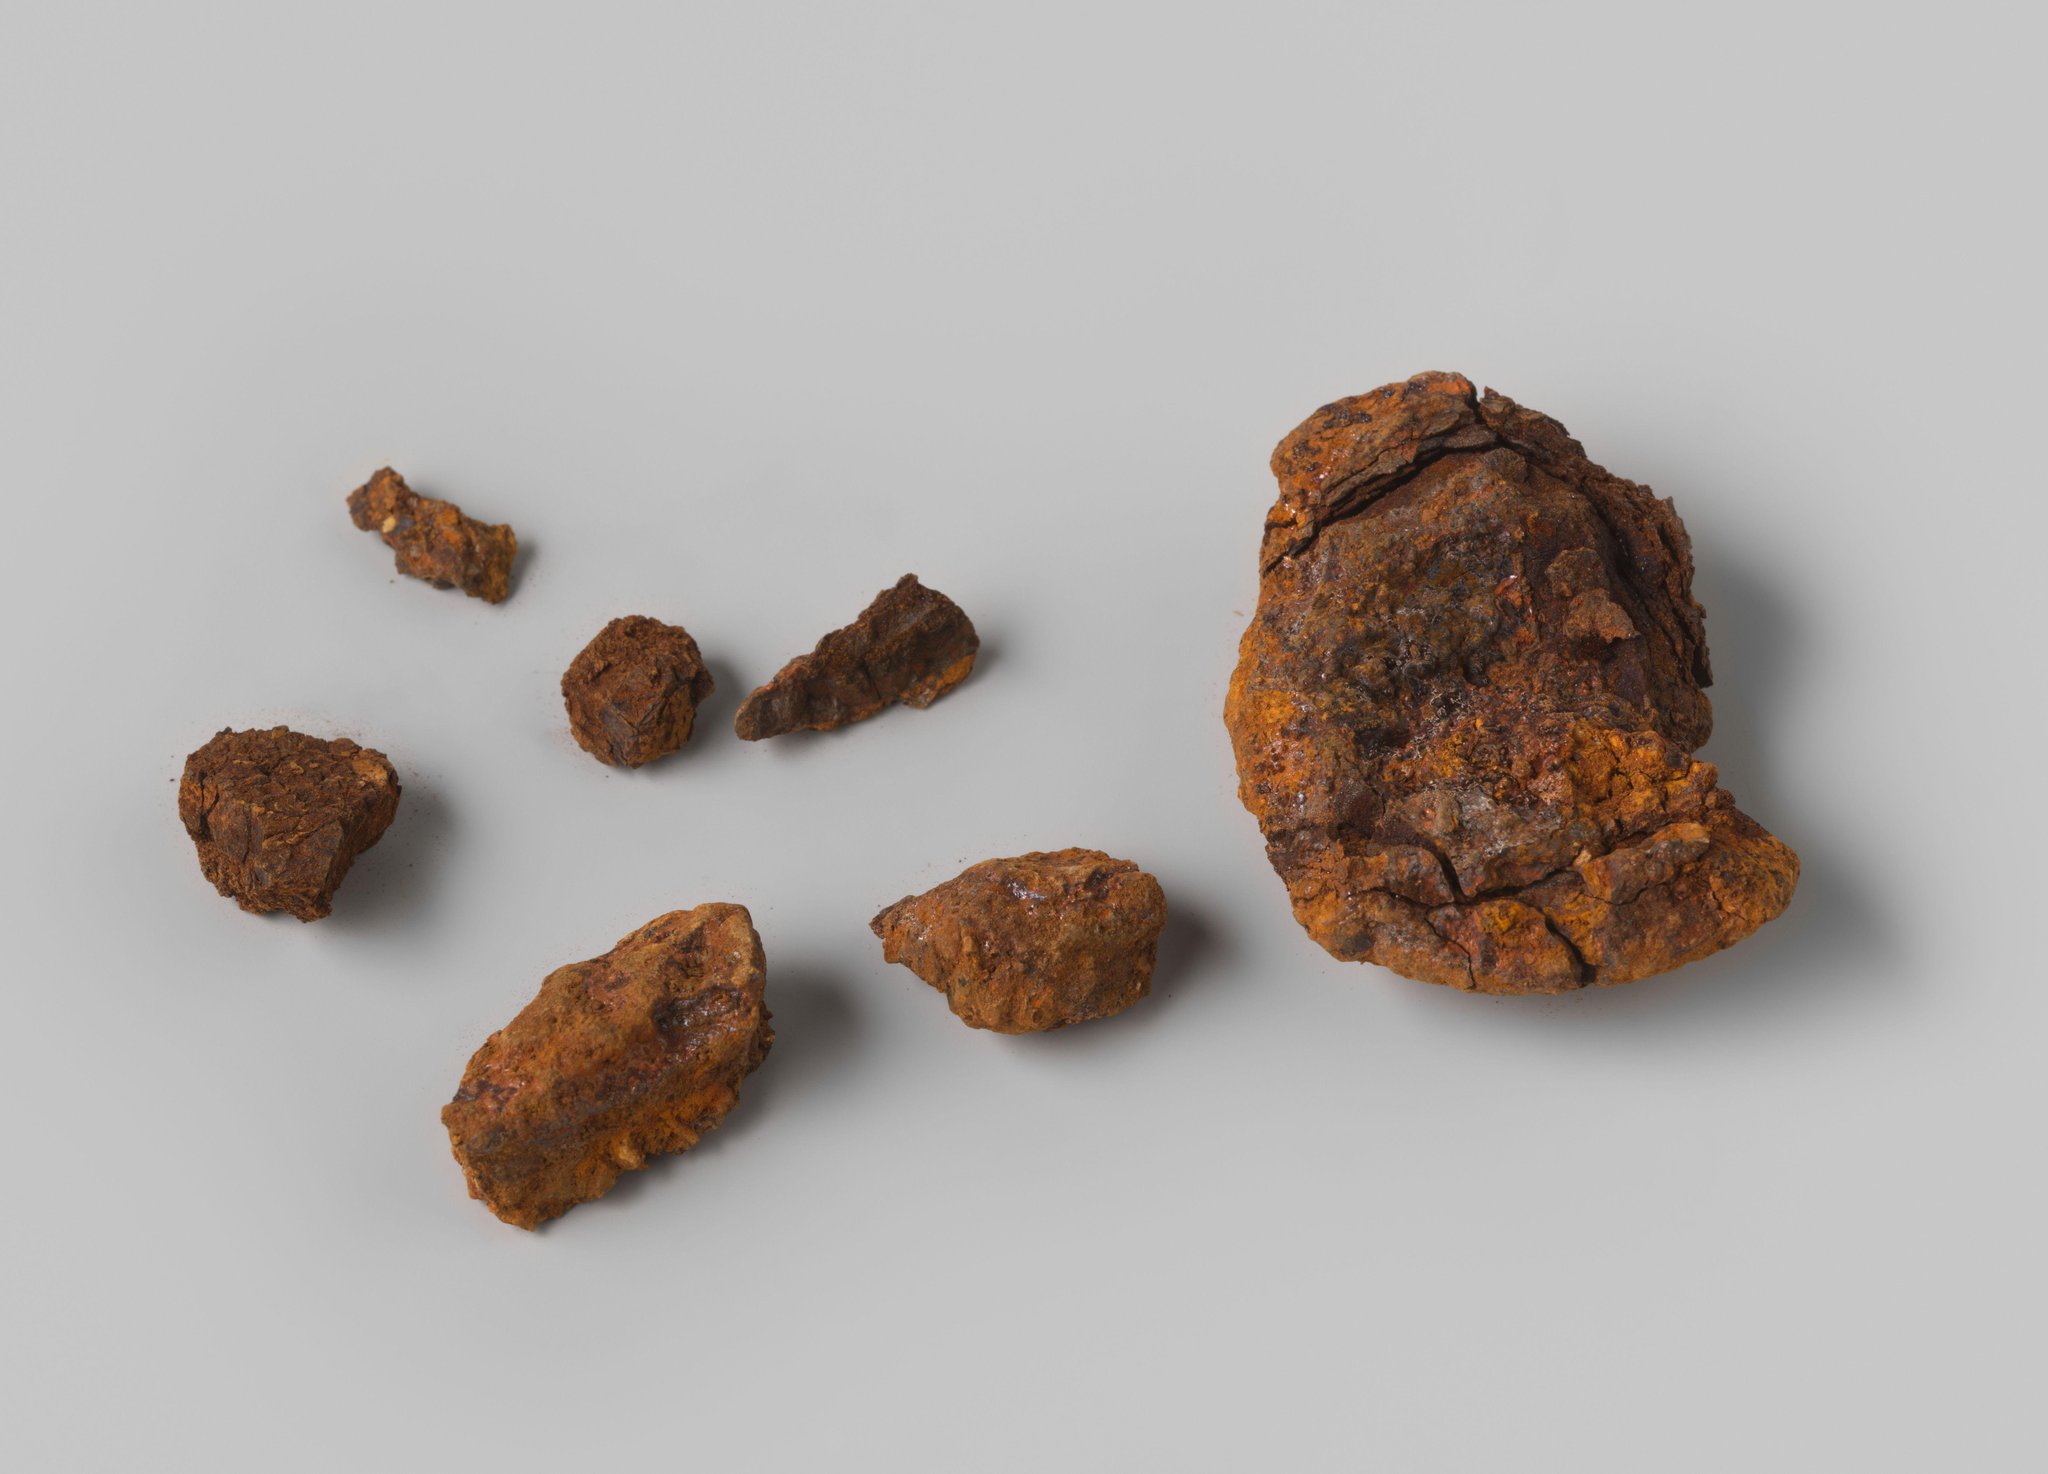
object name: bullet ammunition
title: Fragmenten kogel uit het wrak van de Oost-Indiëvaarder Hollandia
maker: Anonymous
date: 1700-1743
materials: iron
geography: netherlands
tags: verenigde oostindische compagnie, hollandia (schip), annet